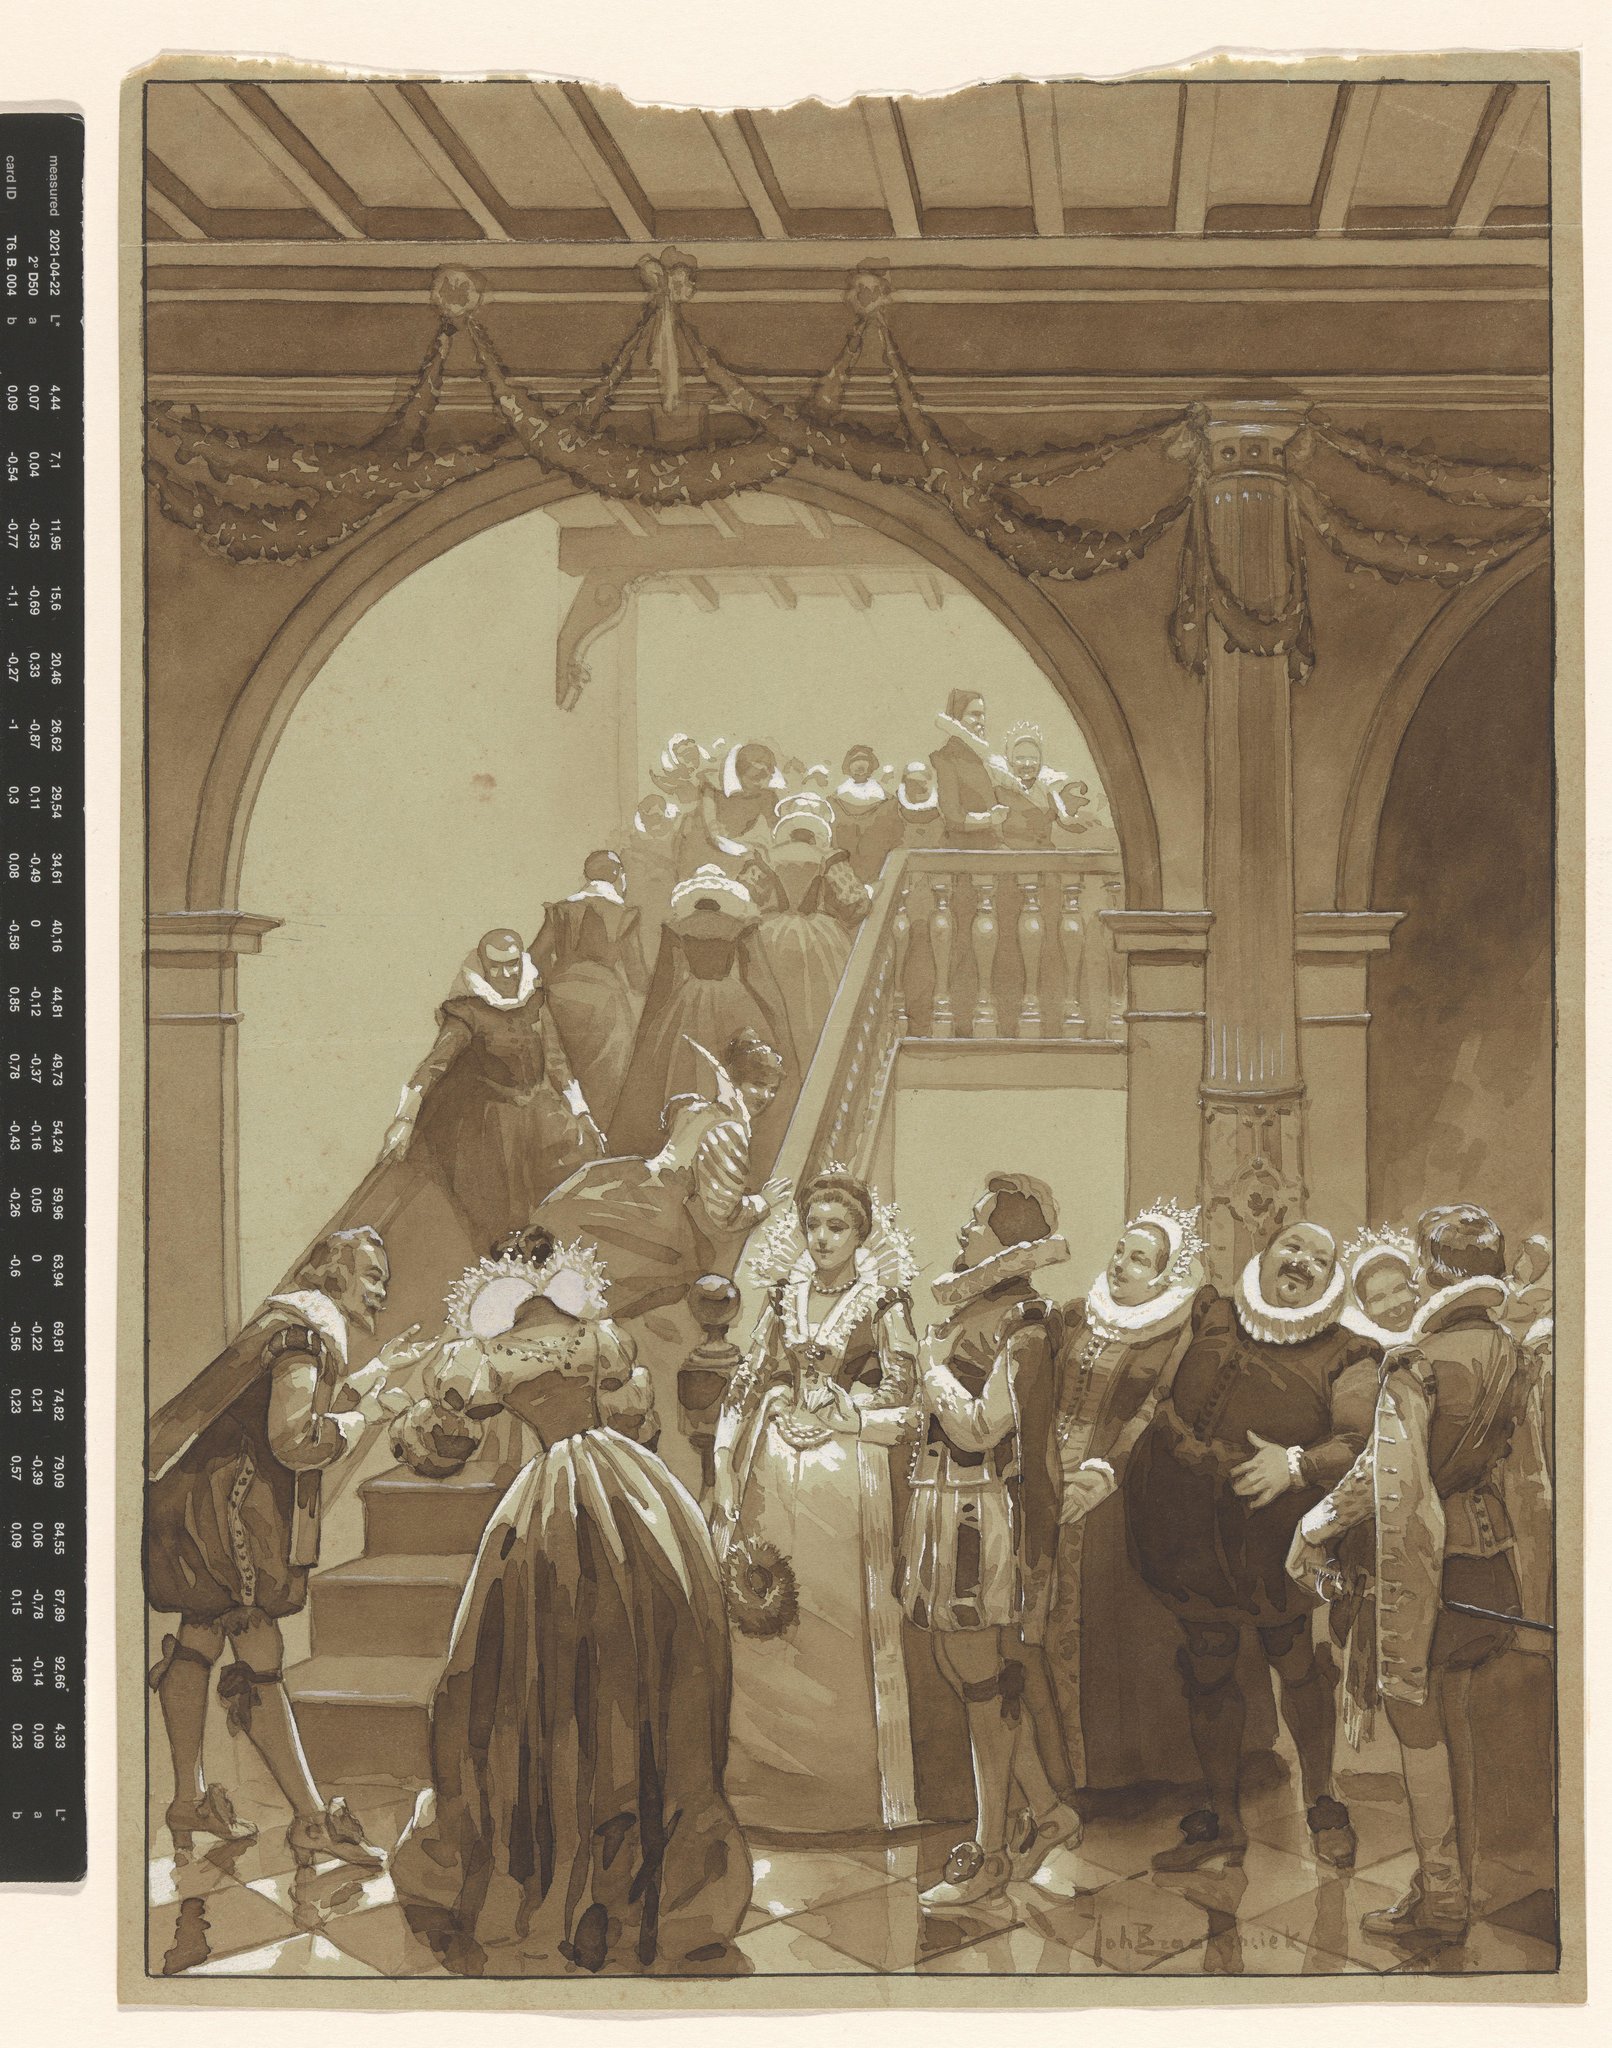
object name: drawing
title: Adel in een trappenhuis in de zeventiende eeuw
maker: johan braakensiek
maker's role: draughtsman, print maker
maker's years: 1858-1940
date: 1868-1940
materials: paper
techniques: brush, pen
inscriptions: signature: ‘JohBraakensiek’